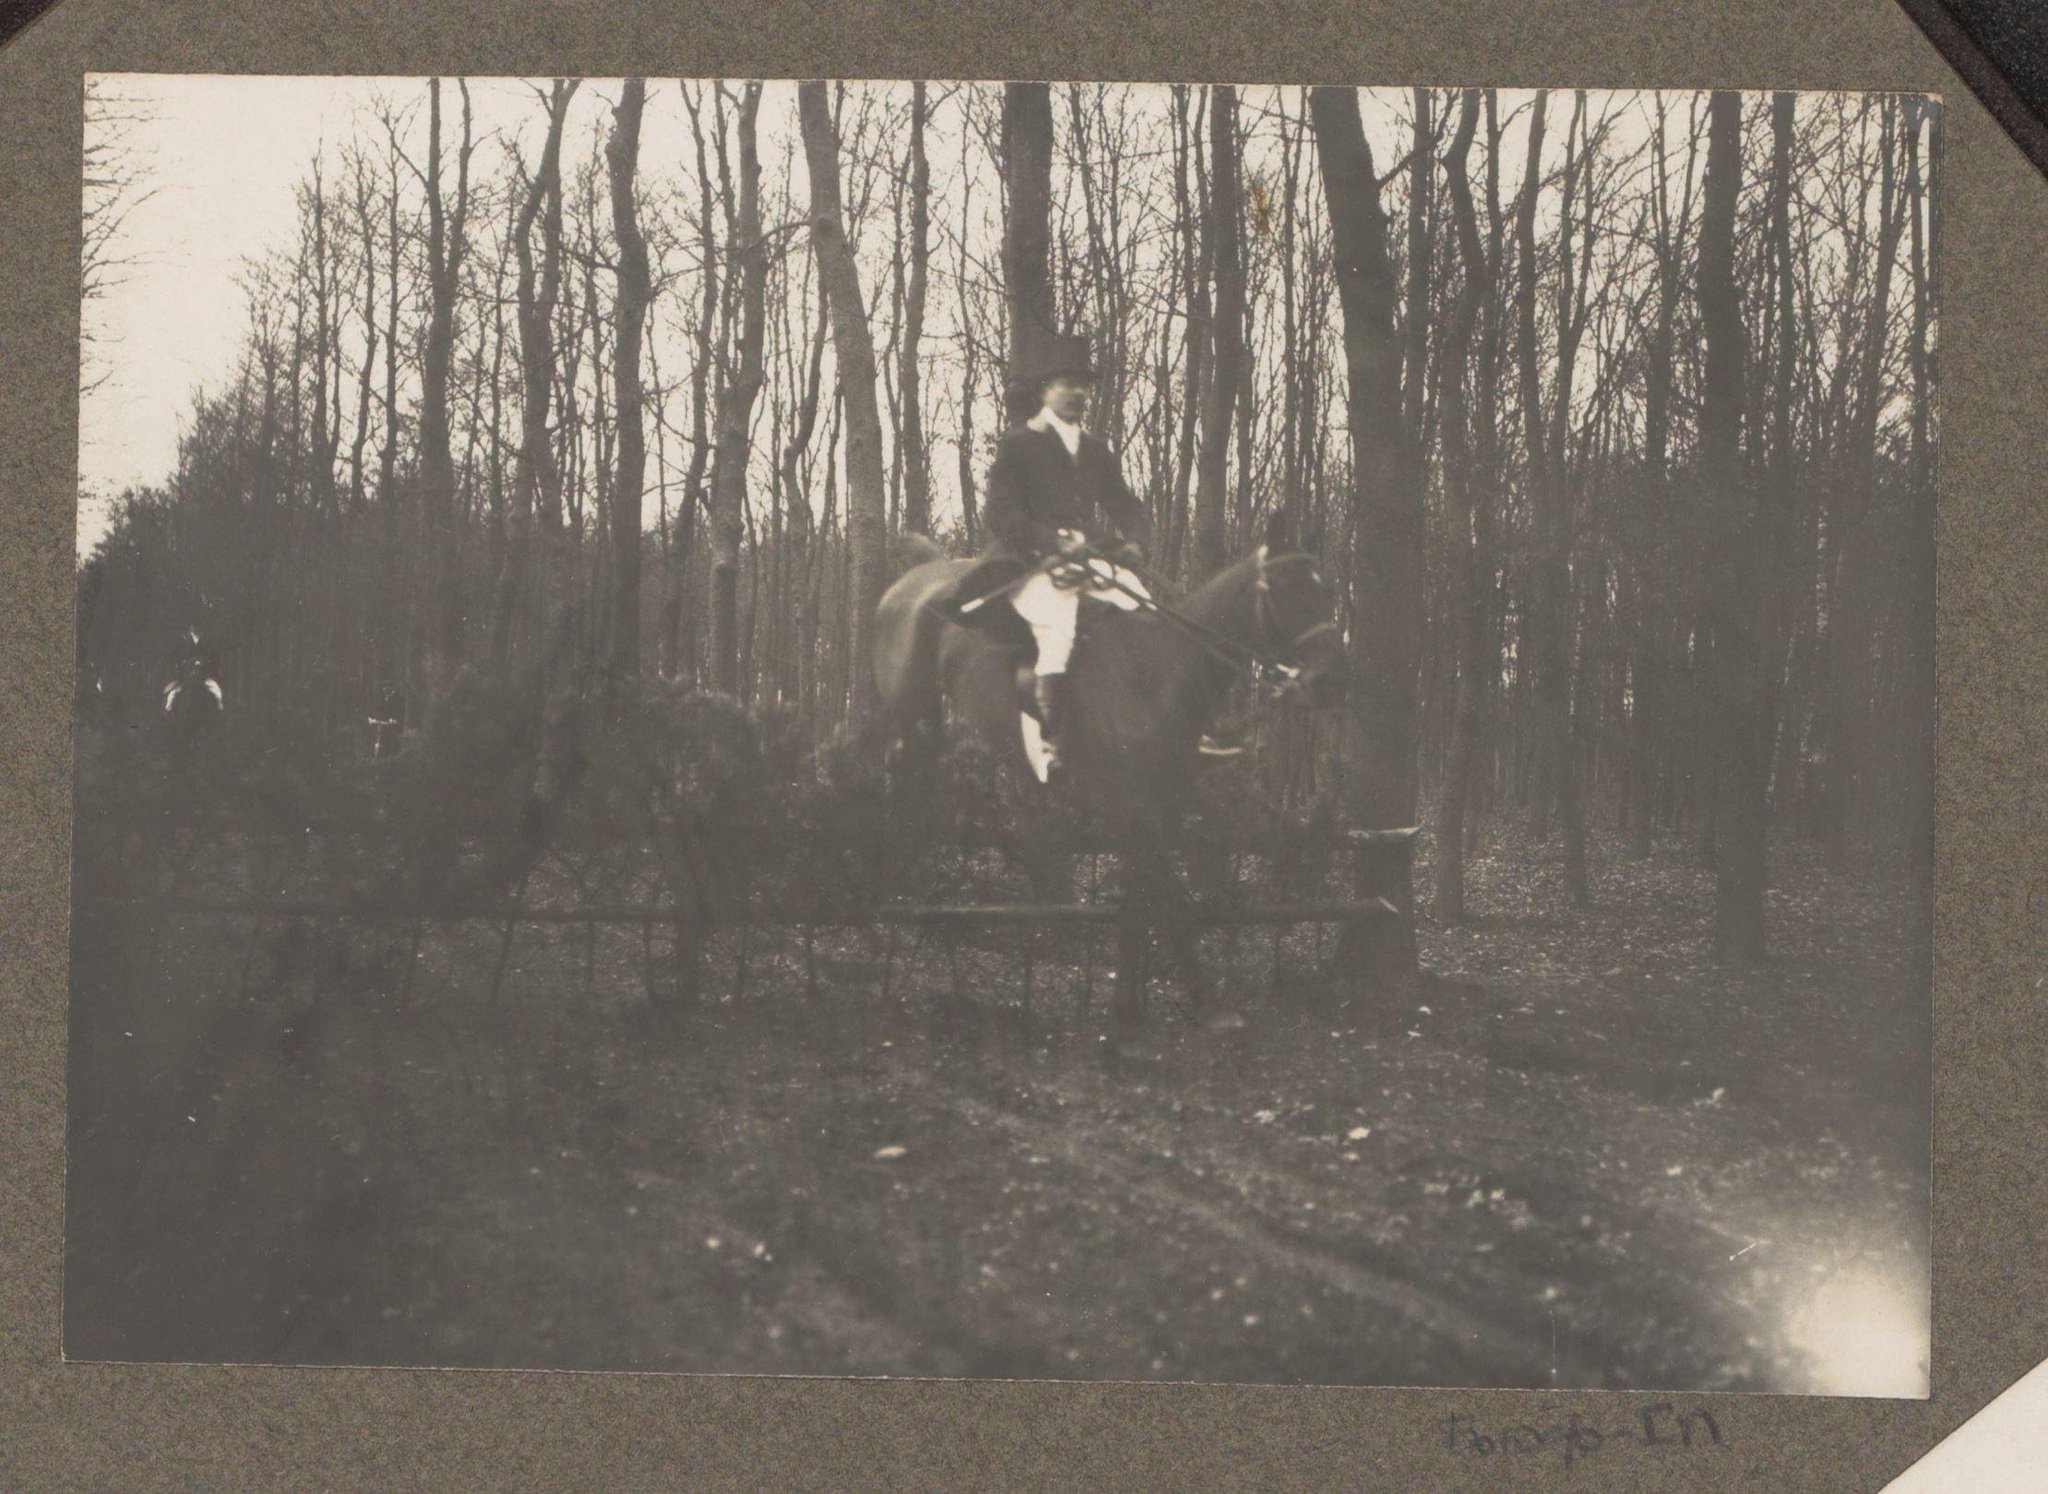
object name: album leaf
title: Ruitertafereel op Koninklijke Houtvesterij Het Loo: ruiter neemt hindernis op een landweg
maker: Anonymous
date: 1900-1925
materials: photographic support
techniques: gelatin silver print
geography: het loo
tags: riding a horse, ass, or mule; rider, horseman, hunting, chase, hunting-ground, forest path or lane, jumping (horse in motion)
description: Onderdeel van Fotoalbum van de heer Brams, opperhoutvester van koningin Wilhelmina op Koninklijke Houtvesterij Het Loo.